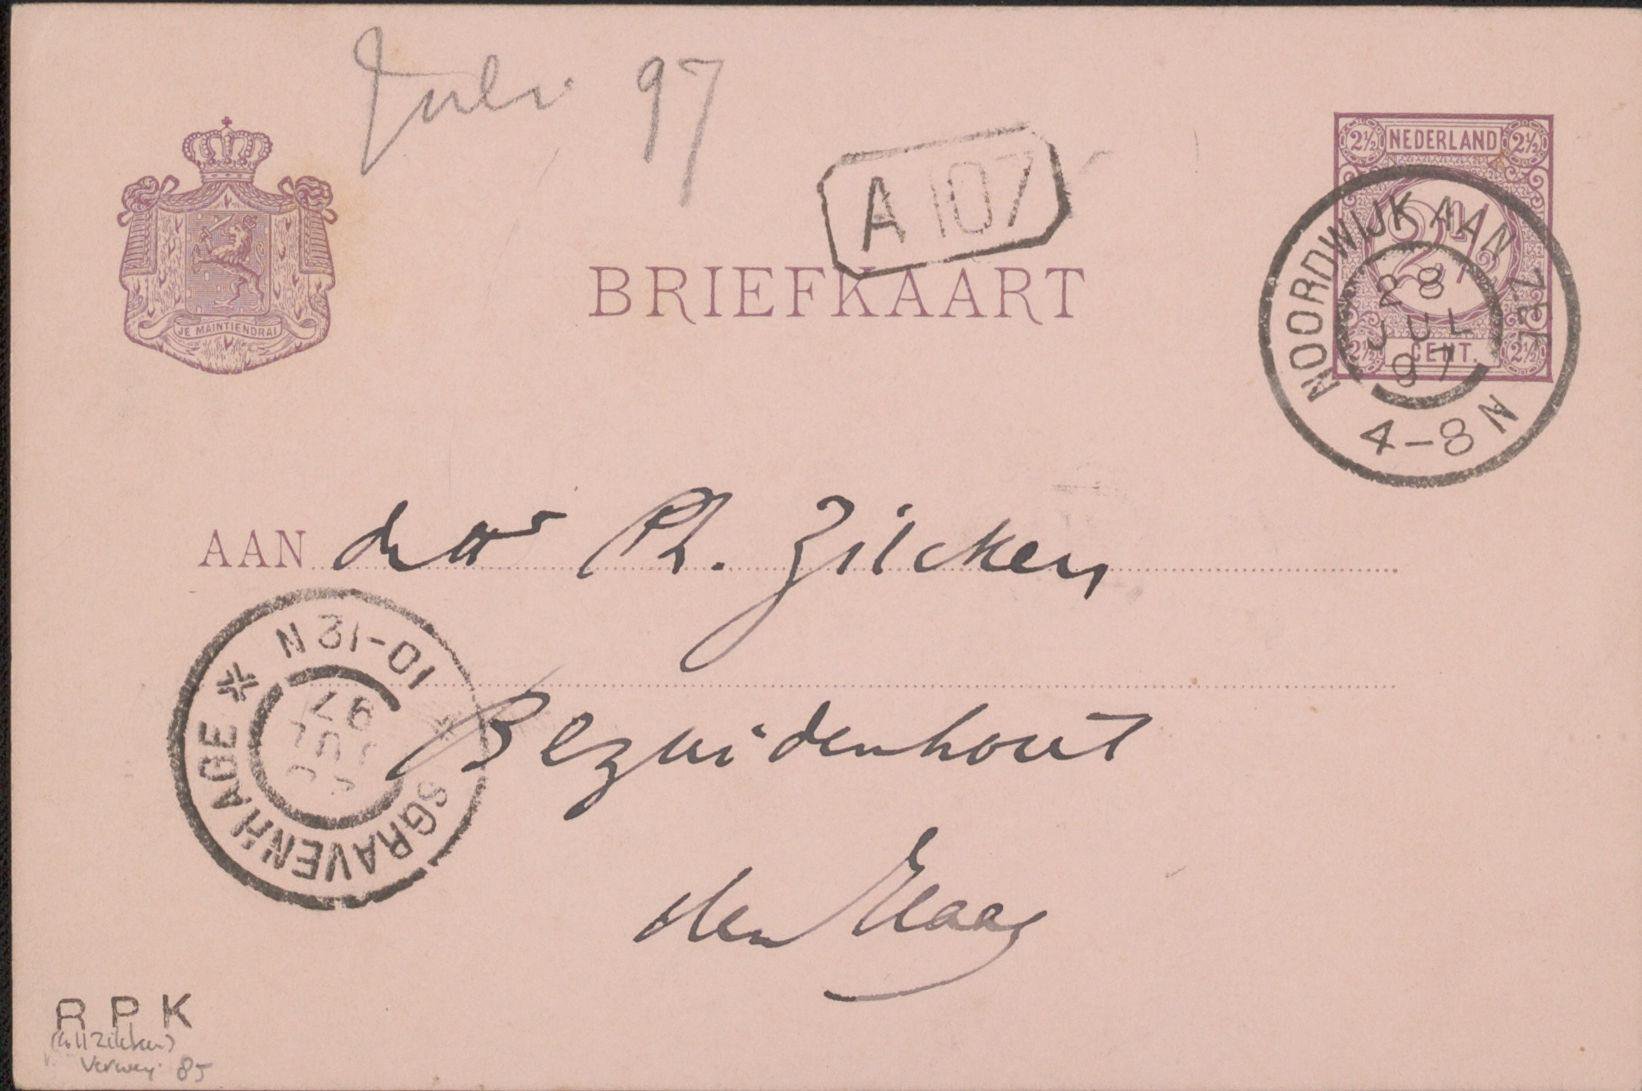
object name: postcard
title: Briefkaart aan Philip Zilcken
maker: albert verwey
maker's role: criticus, dichter, essayist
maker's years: 1865-1937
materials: cardboard, ink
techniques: pen, writing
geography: noordwijk aan zee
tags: the hague, painter, philip zilcken, family life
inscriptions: collector's mark: ‘RPK’